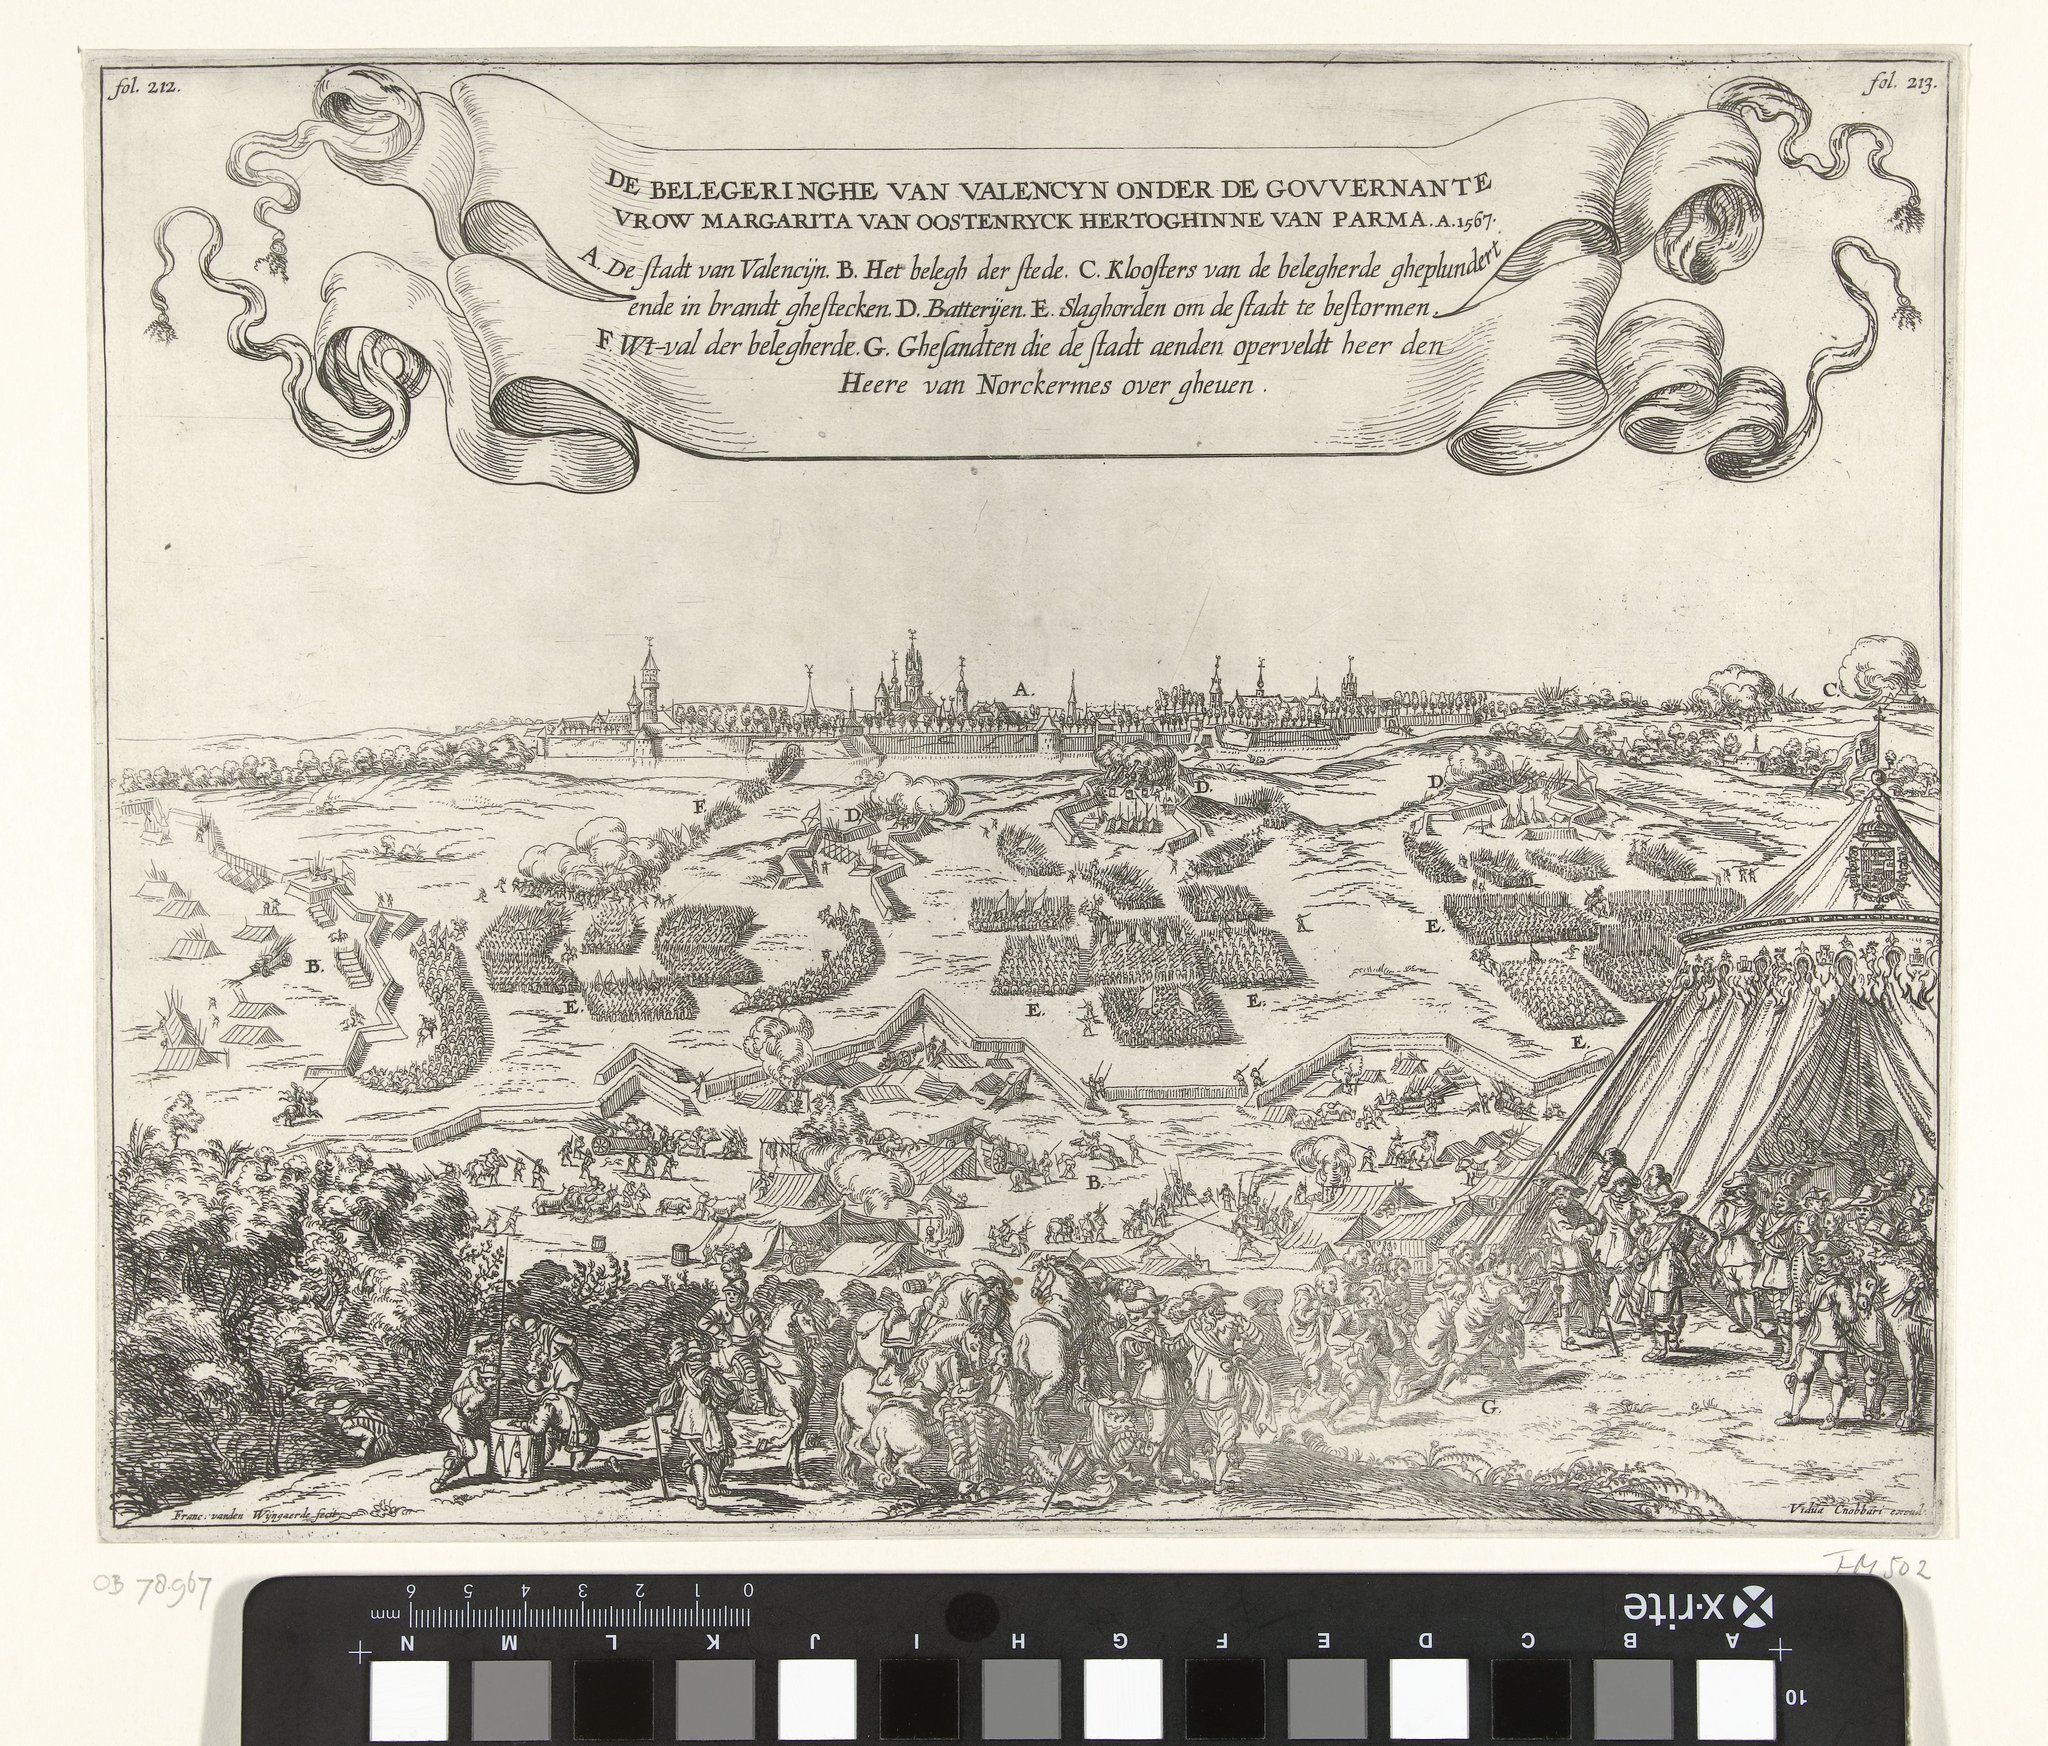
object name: history print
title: Beleg van Valenciennes, 1567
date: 1643-1645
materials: paper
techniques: etching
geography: southern netherlands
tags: capture of city (after the siege)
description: Beleg en inname van Valenciennes, 24 maart 1567. De stad wordt door de heer van Noircarmes heroverd op de calvinisten. Gezicht vanuit het kamp van het leger van Noircarmes. De bewoners van de stad bieden geknield Noircarmes de sleutels van de stad aan. Voor de stad oprukkende troepen en schermutselingen. Bovenin een banderol met de titel en legenda A-F in het Nederlands.